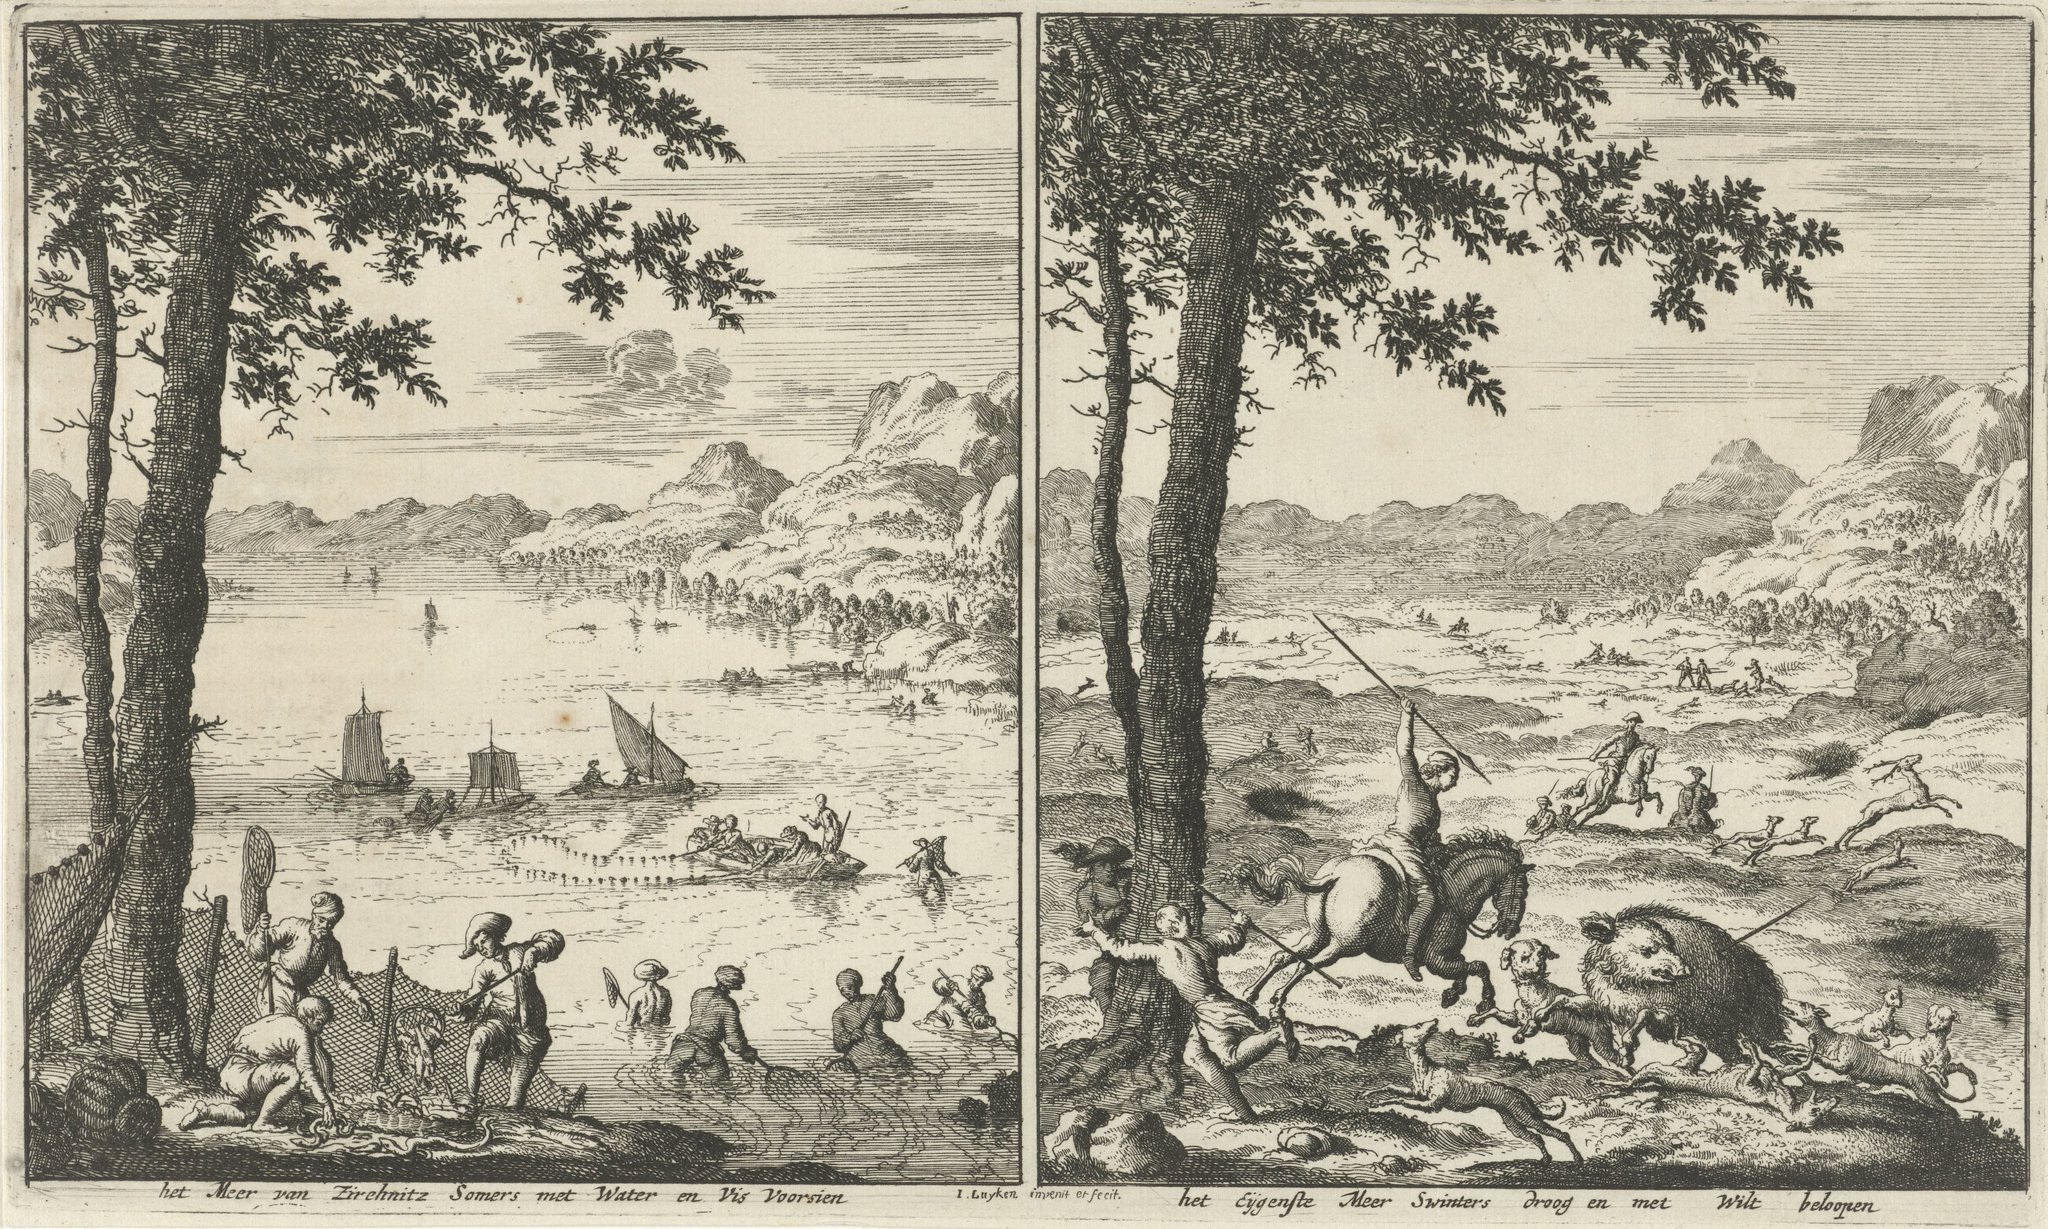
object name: print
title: Het Meer van Zirchnitz Somers met Water en Vis voorsien / het Eijgenste Meer Swinters droog en met Wilt beloopen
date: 1682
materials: paper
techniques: etching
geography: amsterdam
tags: lake, winter landscape; landscape symbolizing winter (the four seasons of the year), summer landscape; landscape symbolizing summer (the four seasons of the year), mountains, austria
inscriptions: collector's mark: Lugt 2228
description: Illustratie opgenomen in: Brown, Edward. Naauwkeurige en gedenkwaardige reysen van Edward Brown (...) door Nederland, Duytsland, Hongaryen, Boek II, p. 141. Amsterdam: Jan Claesz ten Hoorn, 1682.